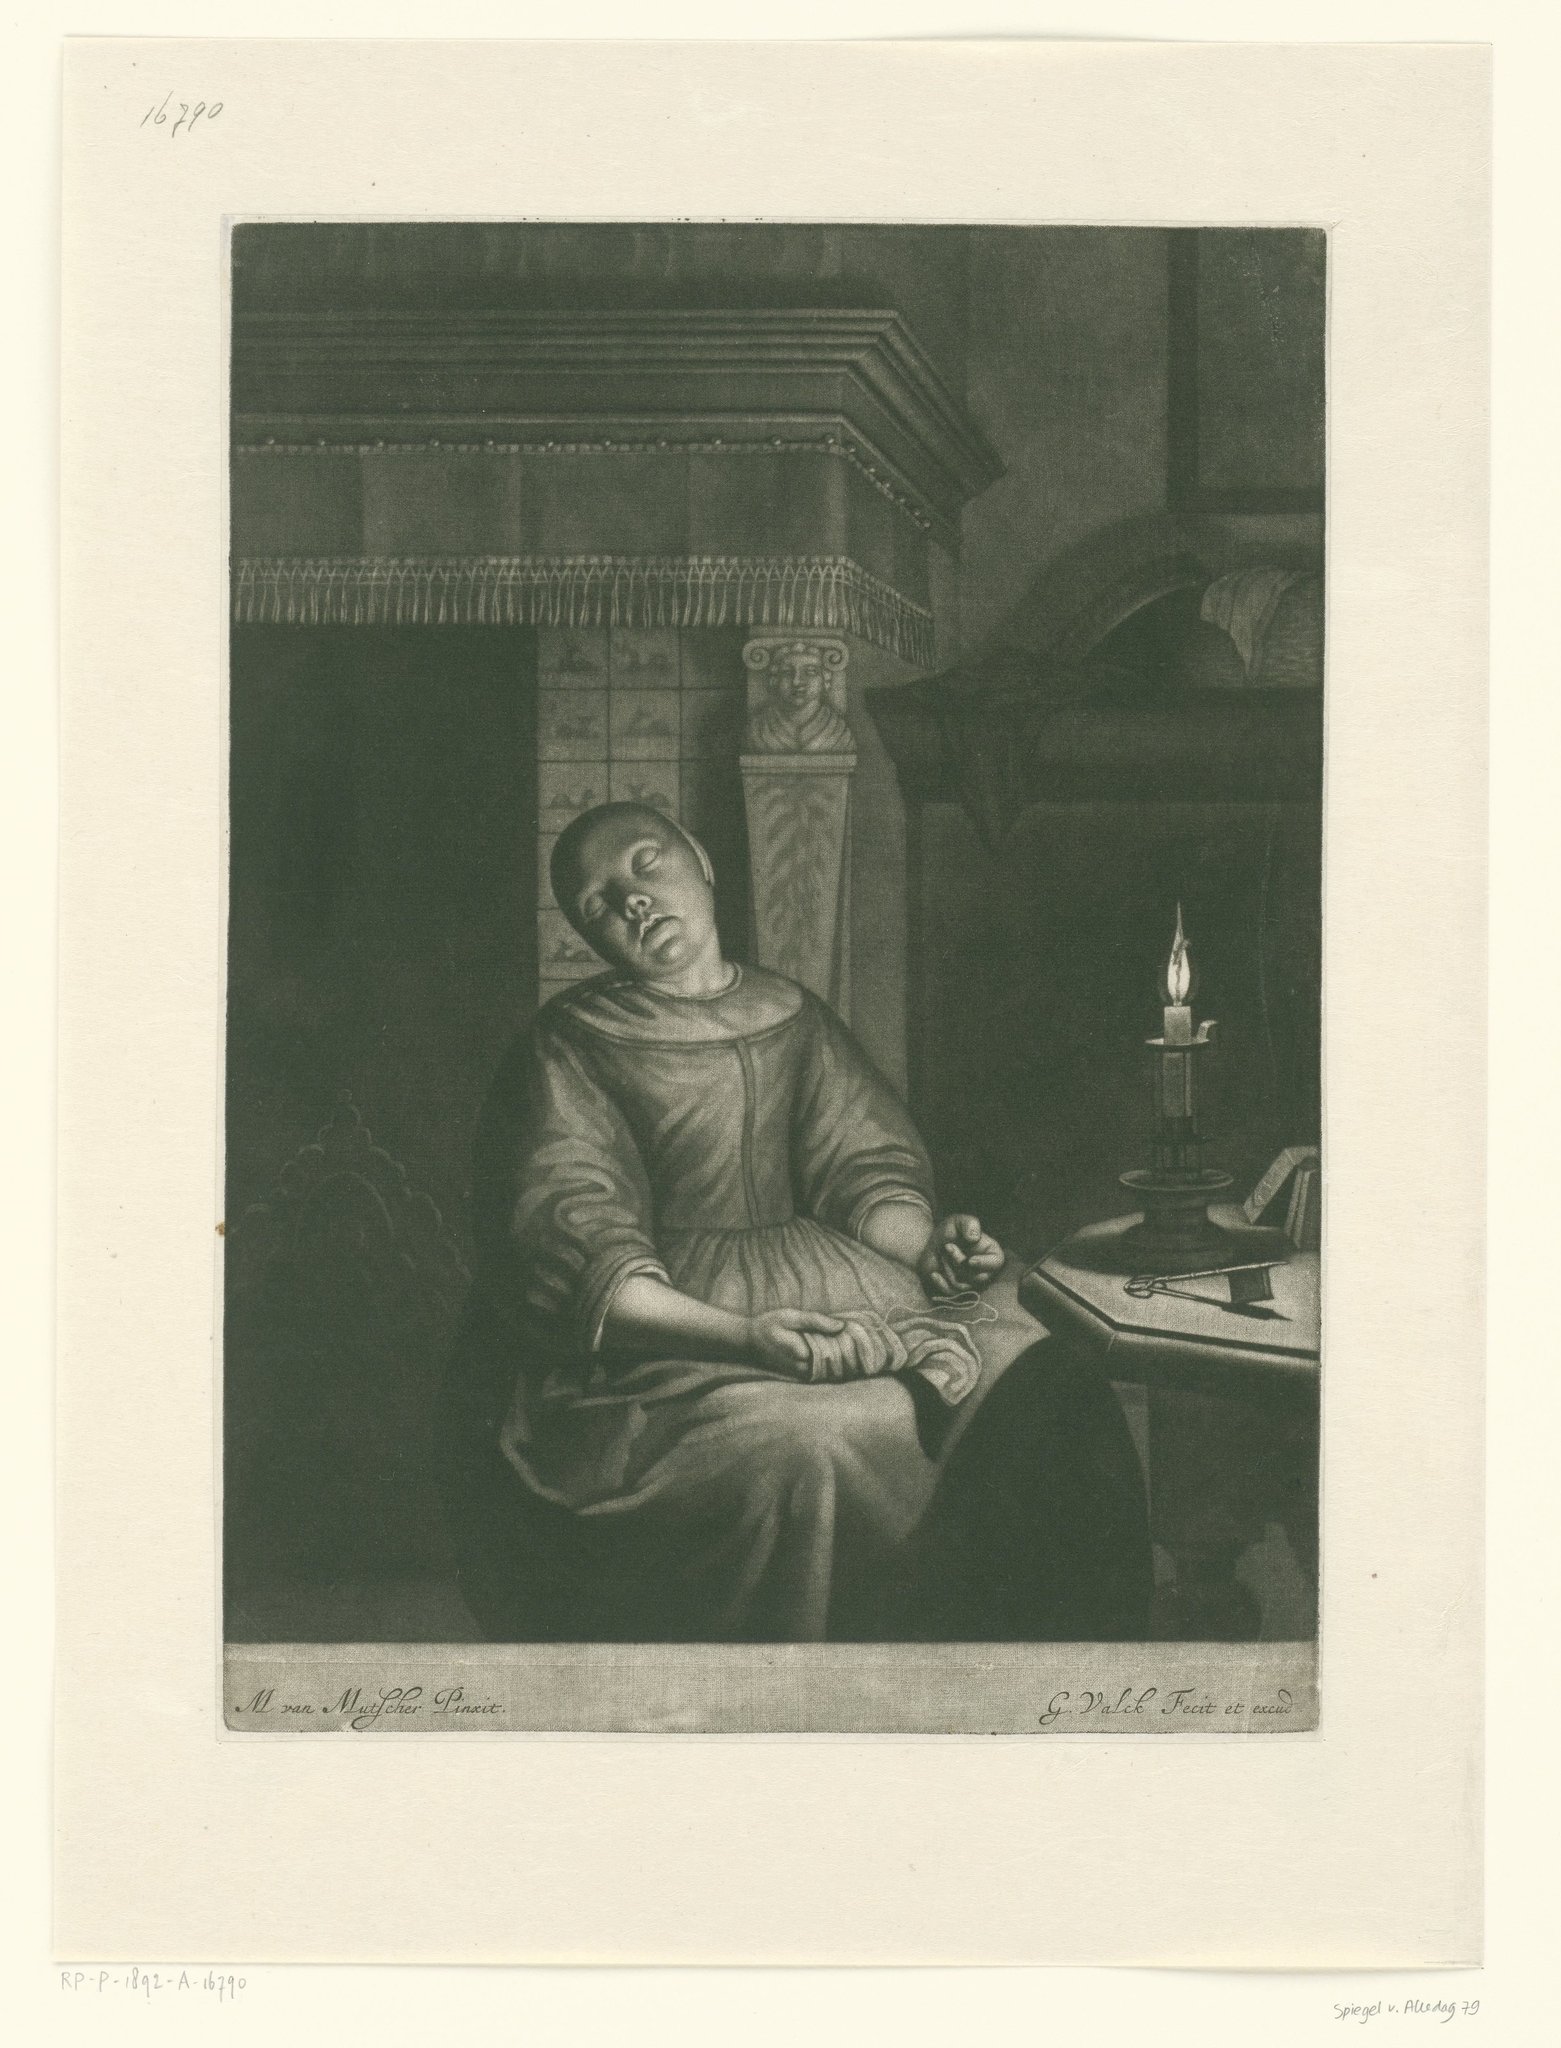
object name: print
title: Slapende vrouw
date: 1662-1726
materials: paper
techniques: mezzotint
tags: chimney, sleeping in chair, needle ~ sewing, candlestick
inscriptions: collector's mark: Lugt 2228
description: Een vrouw, met een naaiwerkje op schoot, zit in een stoel bij de schouw te slapen. Op de tafel naast haar brandt een kaars.